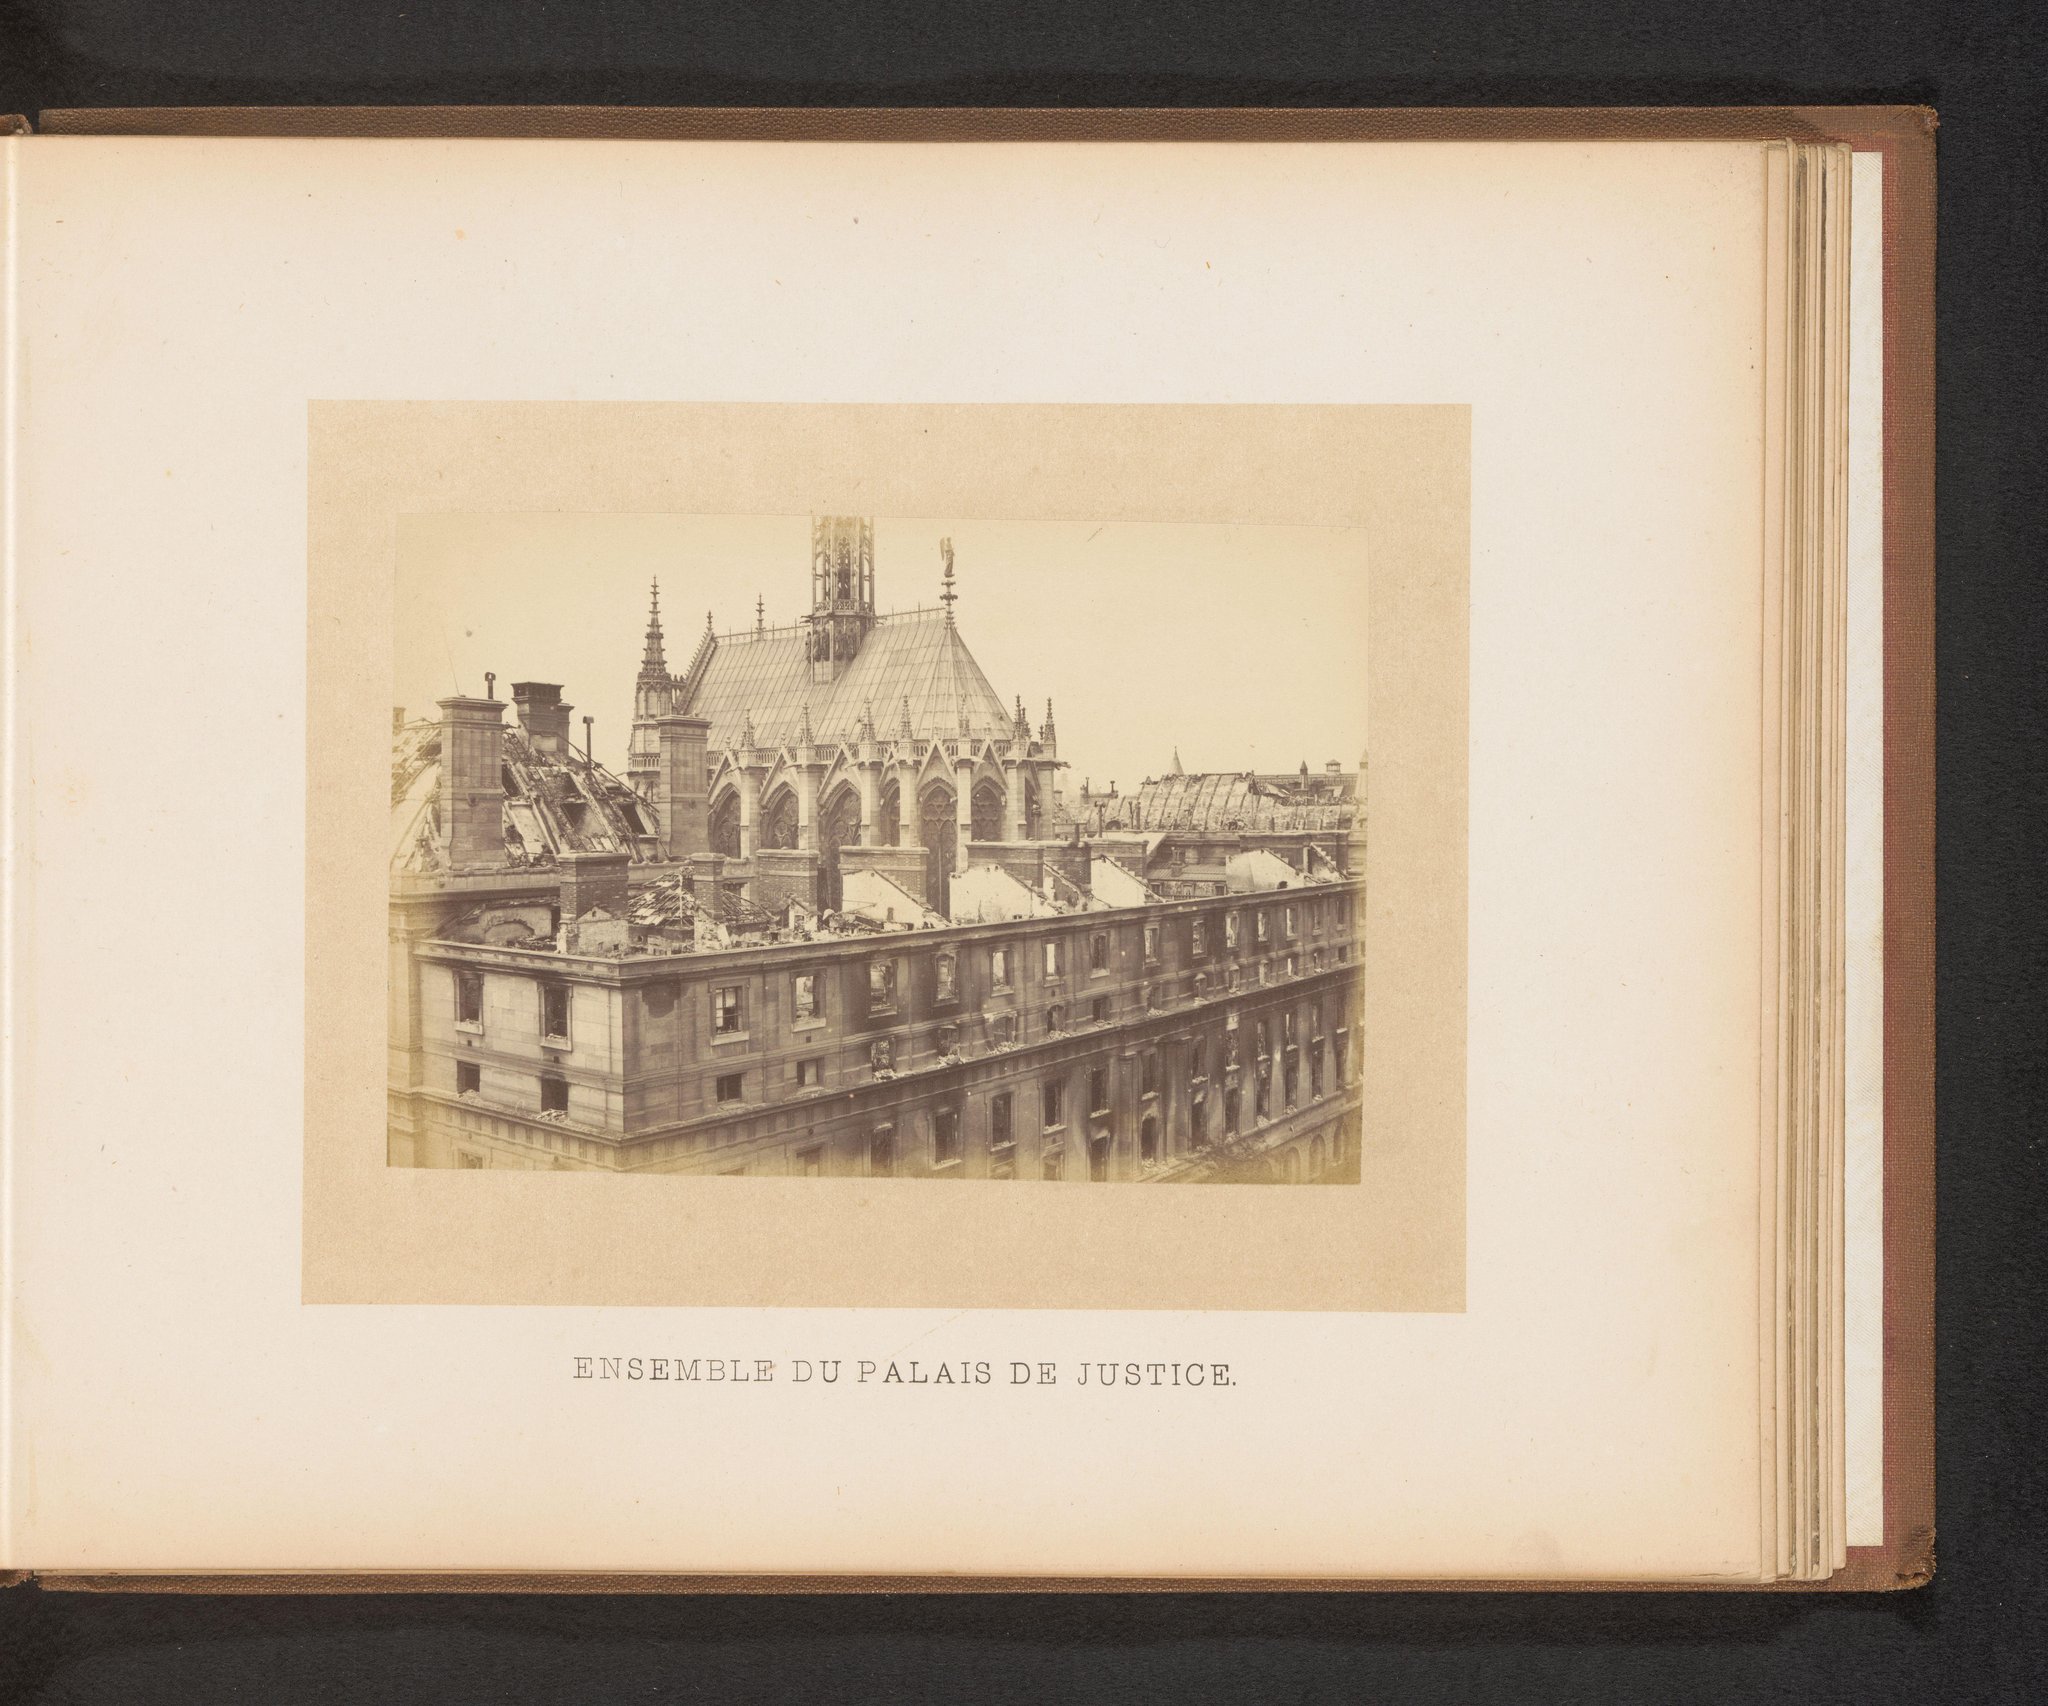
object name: photograph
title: Gezicht op een verwoest Paleis van Justitie te Parijs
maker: Anonymous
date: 1871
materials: photographic support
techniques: albumen print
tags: palace, ruin of a dwelling, house, castle, etc.